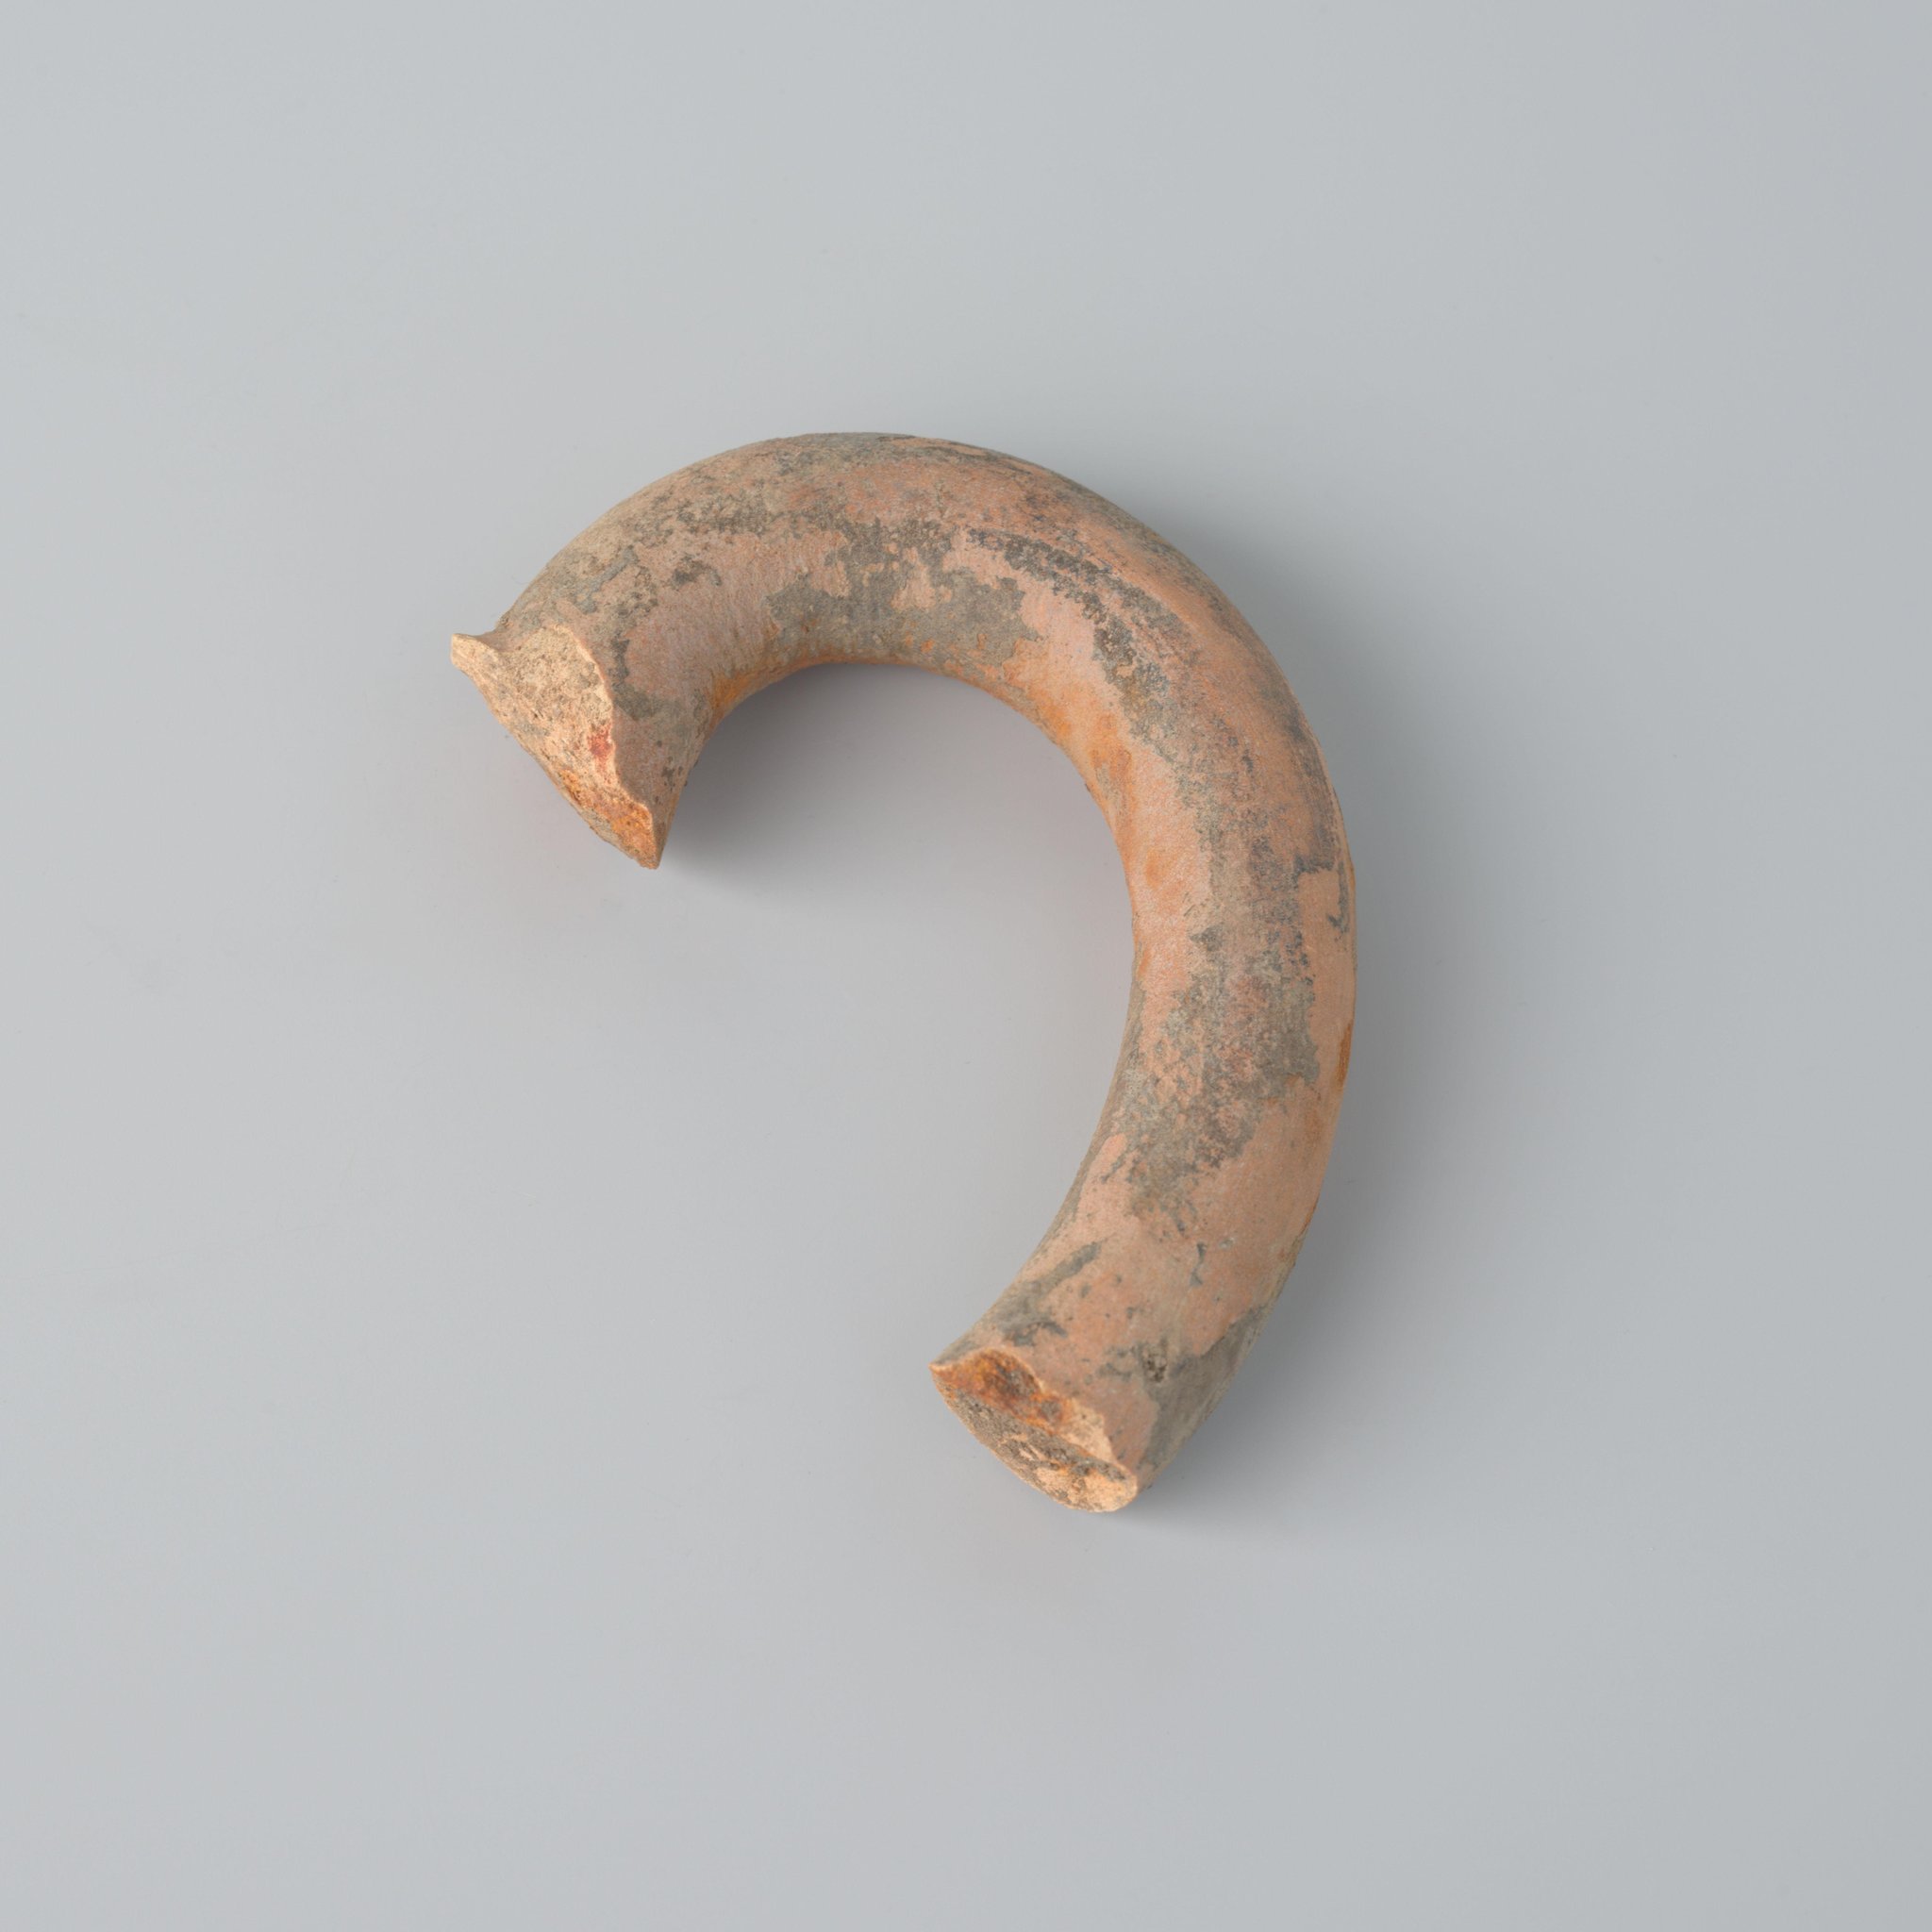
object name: bakafval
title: Oor van een theepot (De Caluwe bakafval)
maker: jacobus de caluwe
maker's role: plateelbakkerij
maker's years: -1730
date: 1700-1725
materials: earthenware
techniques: firing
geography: delft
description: Toegeschreven aan Jacobus de Caluwe, omdat dit voorwerp samen met gemerkte stukken (‘Jacobus De Caluwe’ en rennend hert) gevonden is op de plaats waar zich De Caluwes tweede werkplaats bevond. Er is een duidelijke stilistische overeenkomst tussen de gemerkte en niet gemerkte voorwerpen uit deze archeologische vondst.